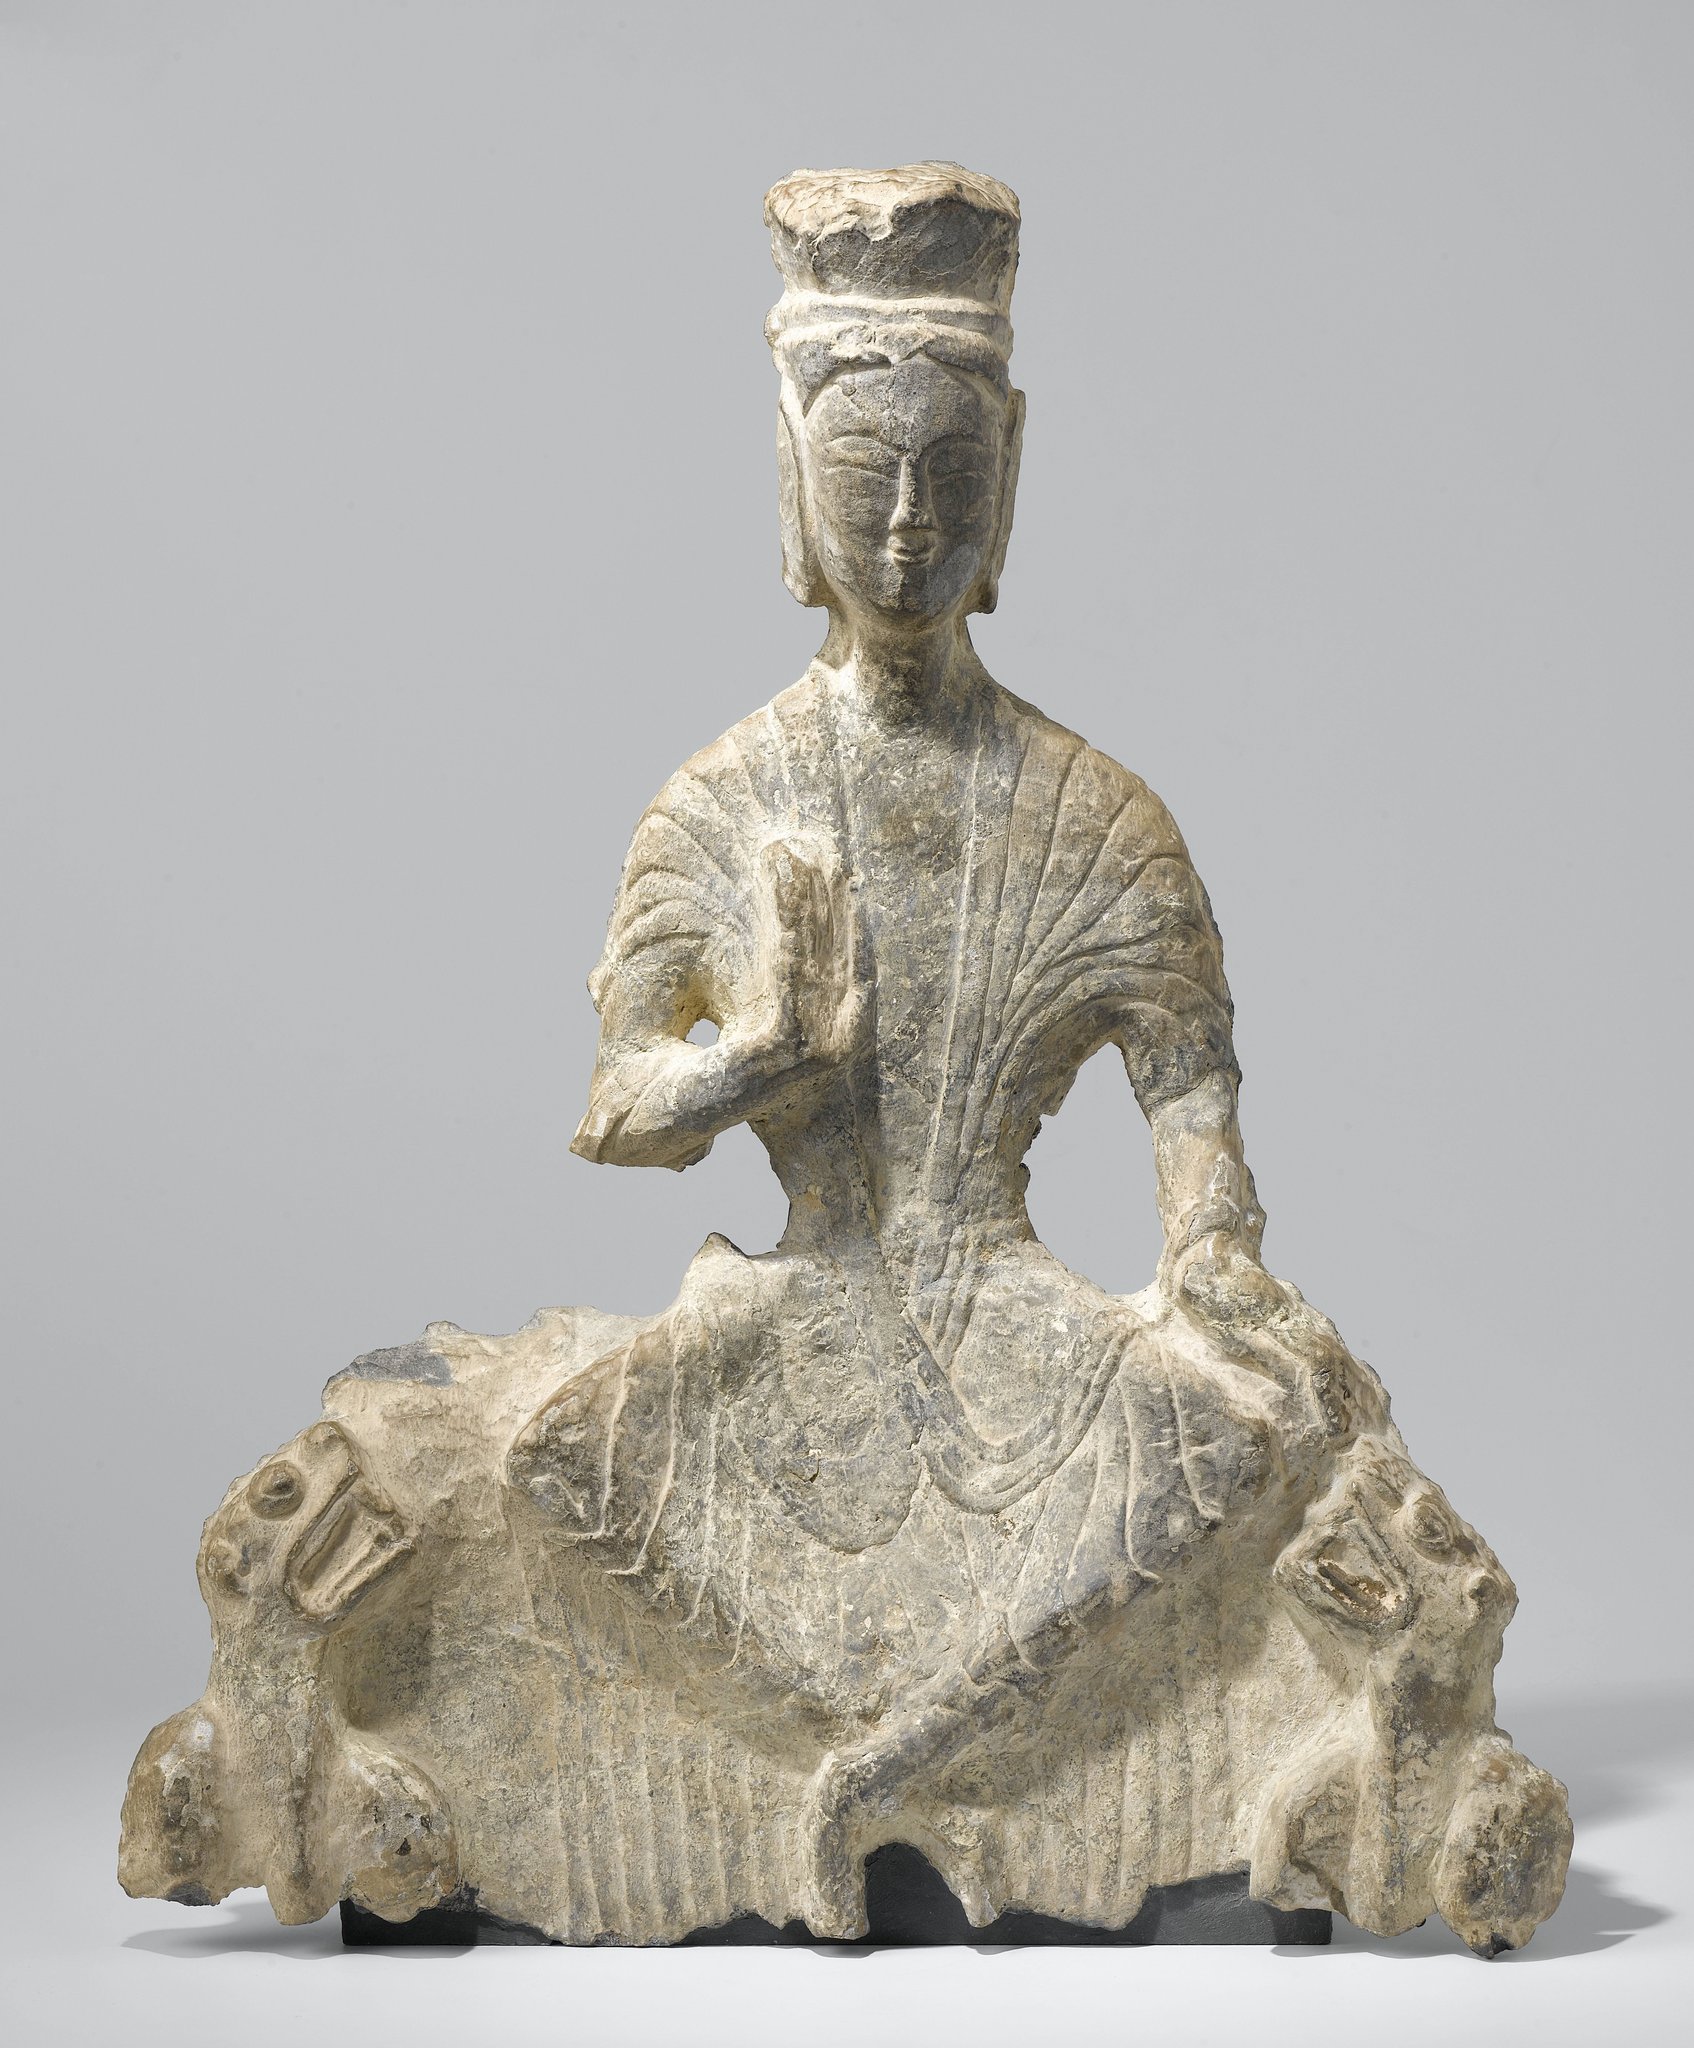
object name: figure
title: The bodhisattva Maitreya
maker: Anonymous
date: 500-525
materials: limestone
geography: longmen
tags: representations ~ gods, demi-gods, heroes, etc. (hinduism, buddhism, jainism), statues, paintings, etc. ~ objects of worship (hinduism, buddhism, jainism)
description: Maitreya, the Buddha of the Future, will appear during the following world cycle and rule an earthly paradise as successor to the Buddha. At present he is still in his heaven, awaiting his descent to earth. This figure comes from Longmen, a complex of Buddhist temples carved from the living rock. The fine stylization of the drapery and the facial features are typical of sculpture from this site.